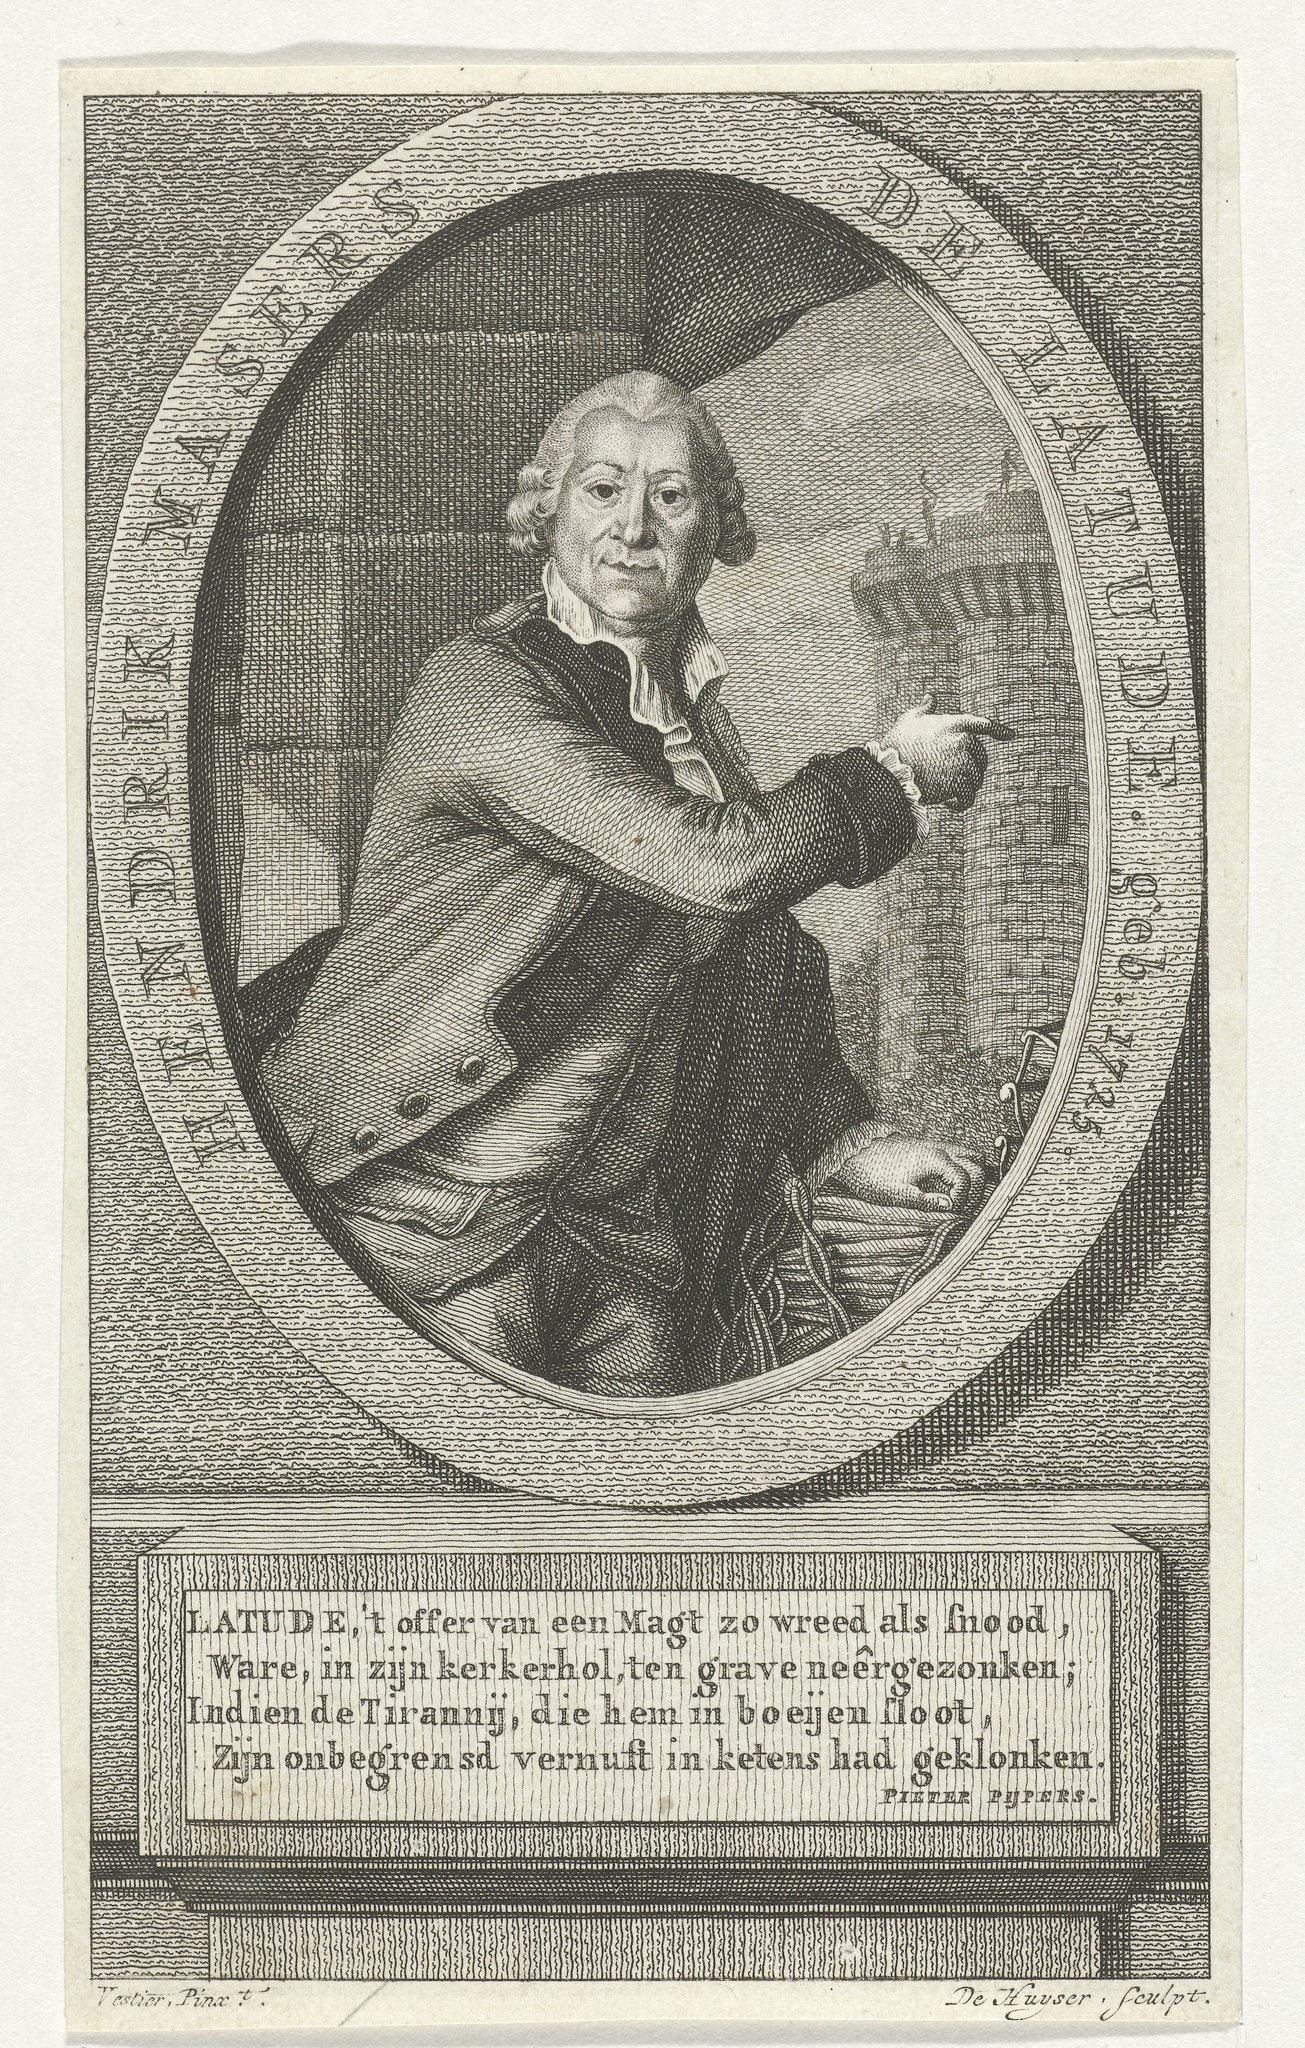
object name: print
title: Portret van Jean Henri Latude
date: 1763-1804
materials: paper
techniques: engraving, etching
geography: amsterdam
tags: jean henri latude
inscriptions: collector's mark: Lugt 2228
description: Portret van Jean Henri Latude ten halven lijve wijzend door een venster naar een burcht met een venster. Portret in een ovale lijst met randschrift, onder een vierregelig vers in het Nederlands.